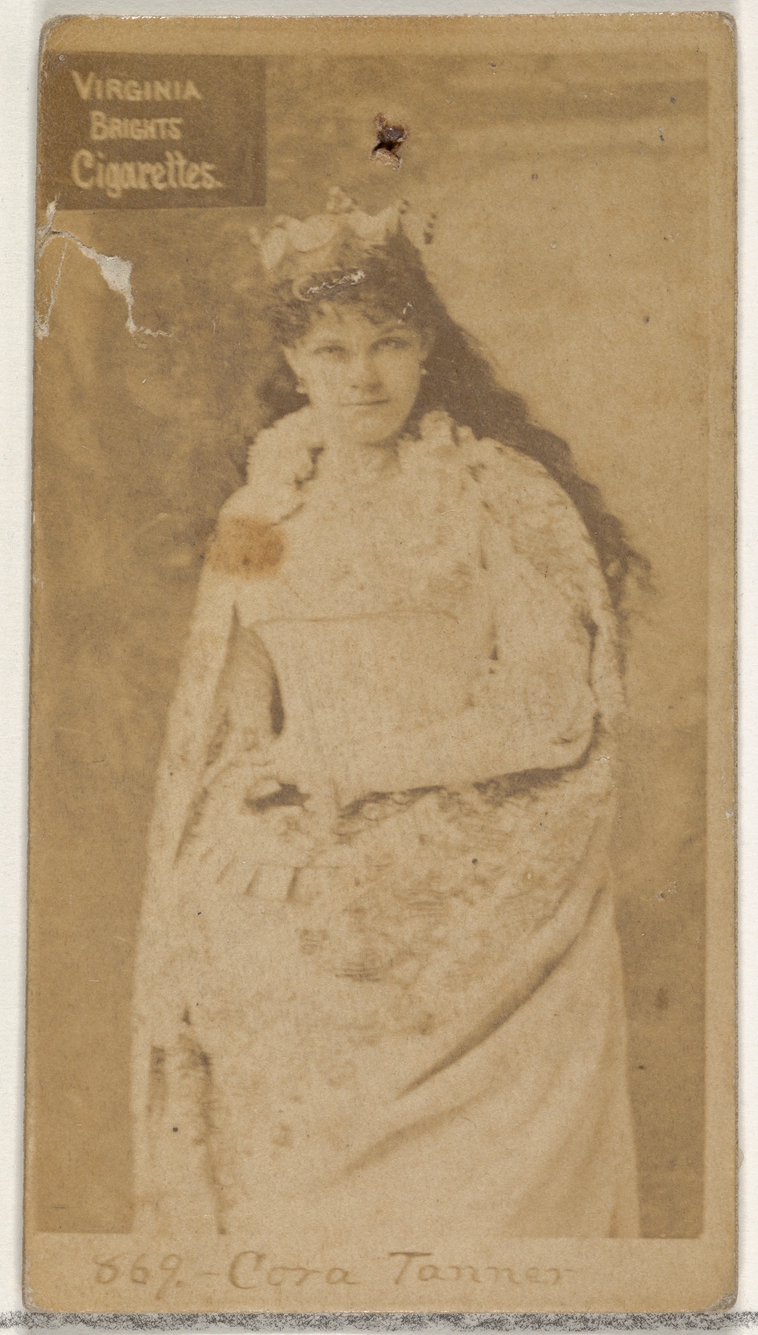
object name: photograph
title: Card 869, Cora Tanner, from the Actors and Actresses series (N45, Type 2) for Virginia Brights Cigarettes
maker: allen & ginter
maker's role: publisher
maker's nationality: american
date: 1888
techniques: albumen silver print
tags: portraits,women,actresses